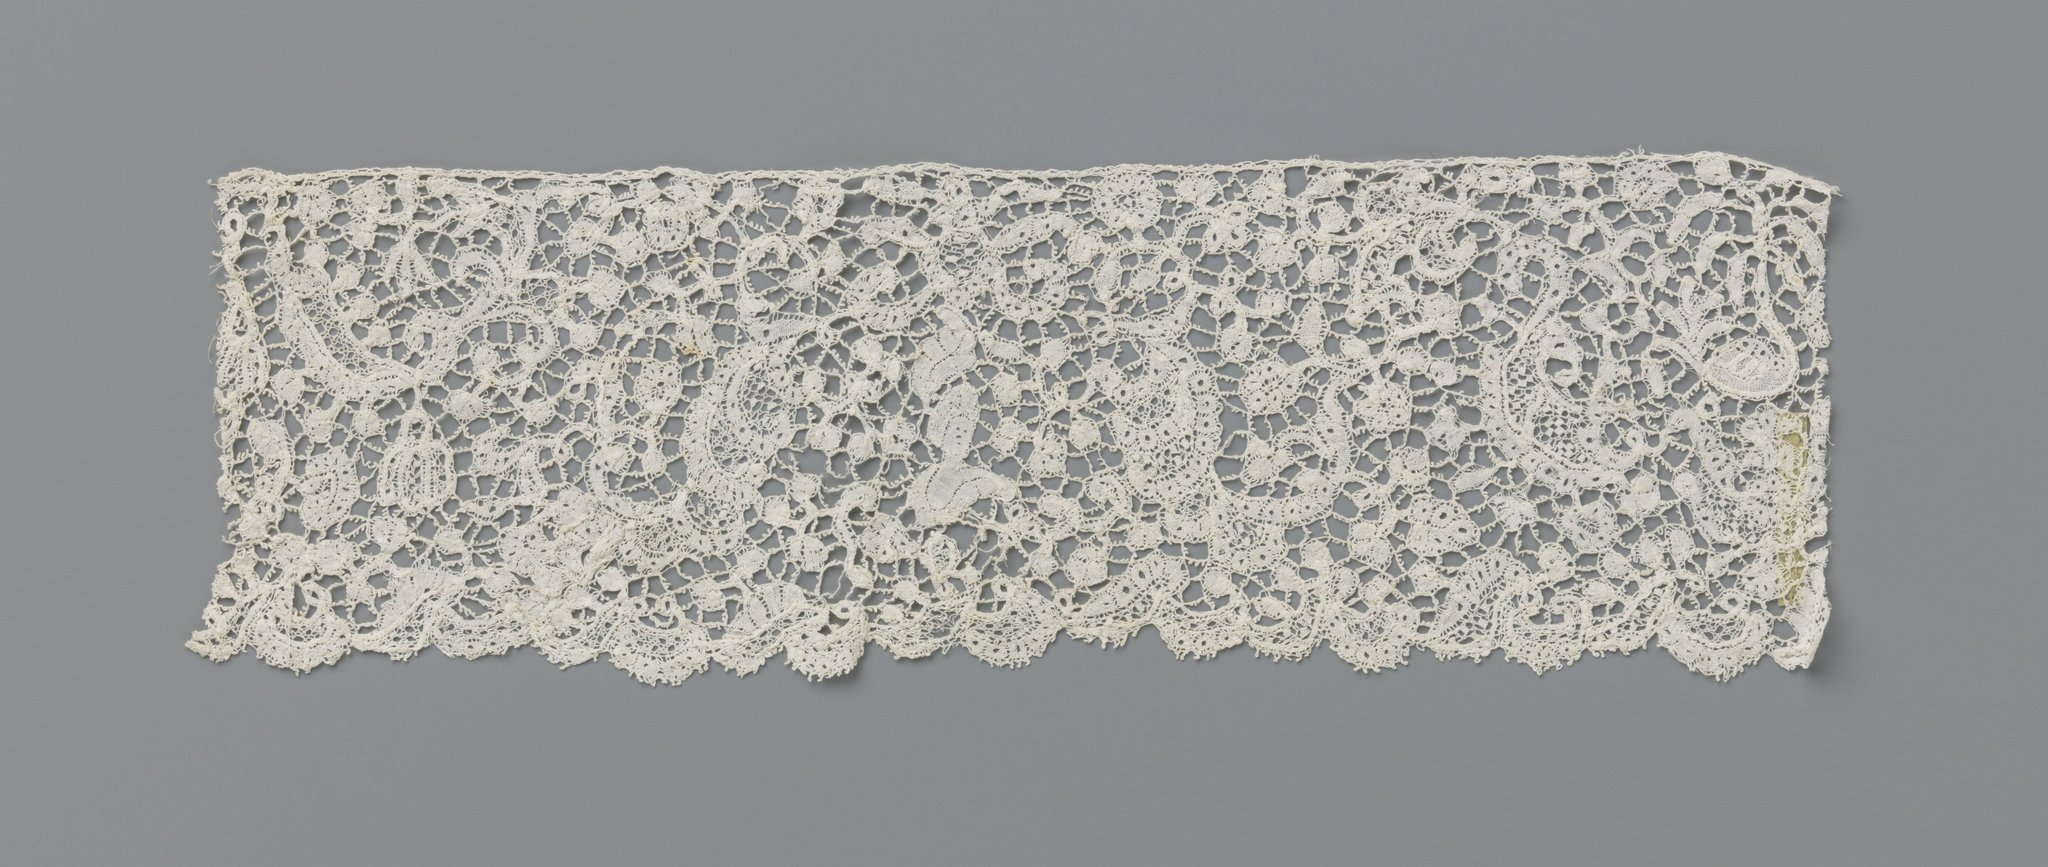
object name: strip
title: Strook kloskant met vrouwenborstbeeldje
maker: Anonymous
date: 1700-1724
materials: linen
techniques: lace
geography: brussels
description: Strook naturelkleurige Brusselse kloskant. Het patroon bestaat uit vele kleine motiefjes, waarbij het vrouwenborstbeeldje in het midden opvalt. Langs de onderzijde zijn veelal c-vormige motiefjes aaneengeschakeld tot een rand met schulpjes. De motieven zijn met elkaar verbonden door gepicoteerde vlechten. De motieven zijn gemaakt in linnenslag met uitsparingen, deels met opengewerkte randjes en deels met gekloste reliëfcontouren. Er zijn verschillende siergronden toegepast in de motiefjes, waaronder een siergrond met vierkantjes gemaakt in vormslag. De bovenzijde is recht afgewerkt. De schulpjes langs onderzijde zijn afgewerkt met picots.